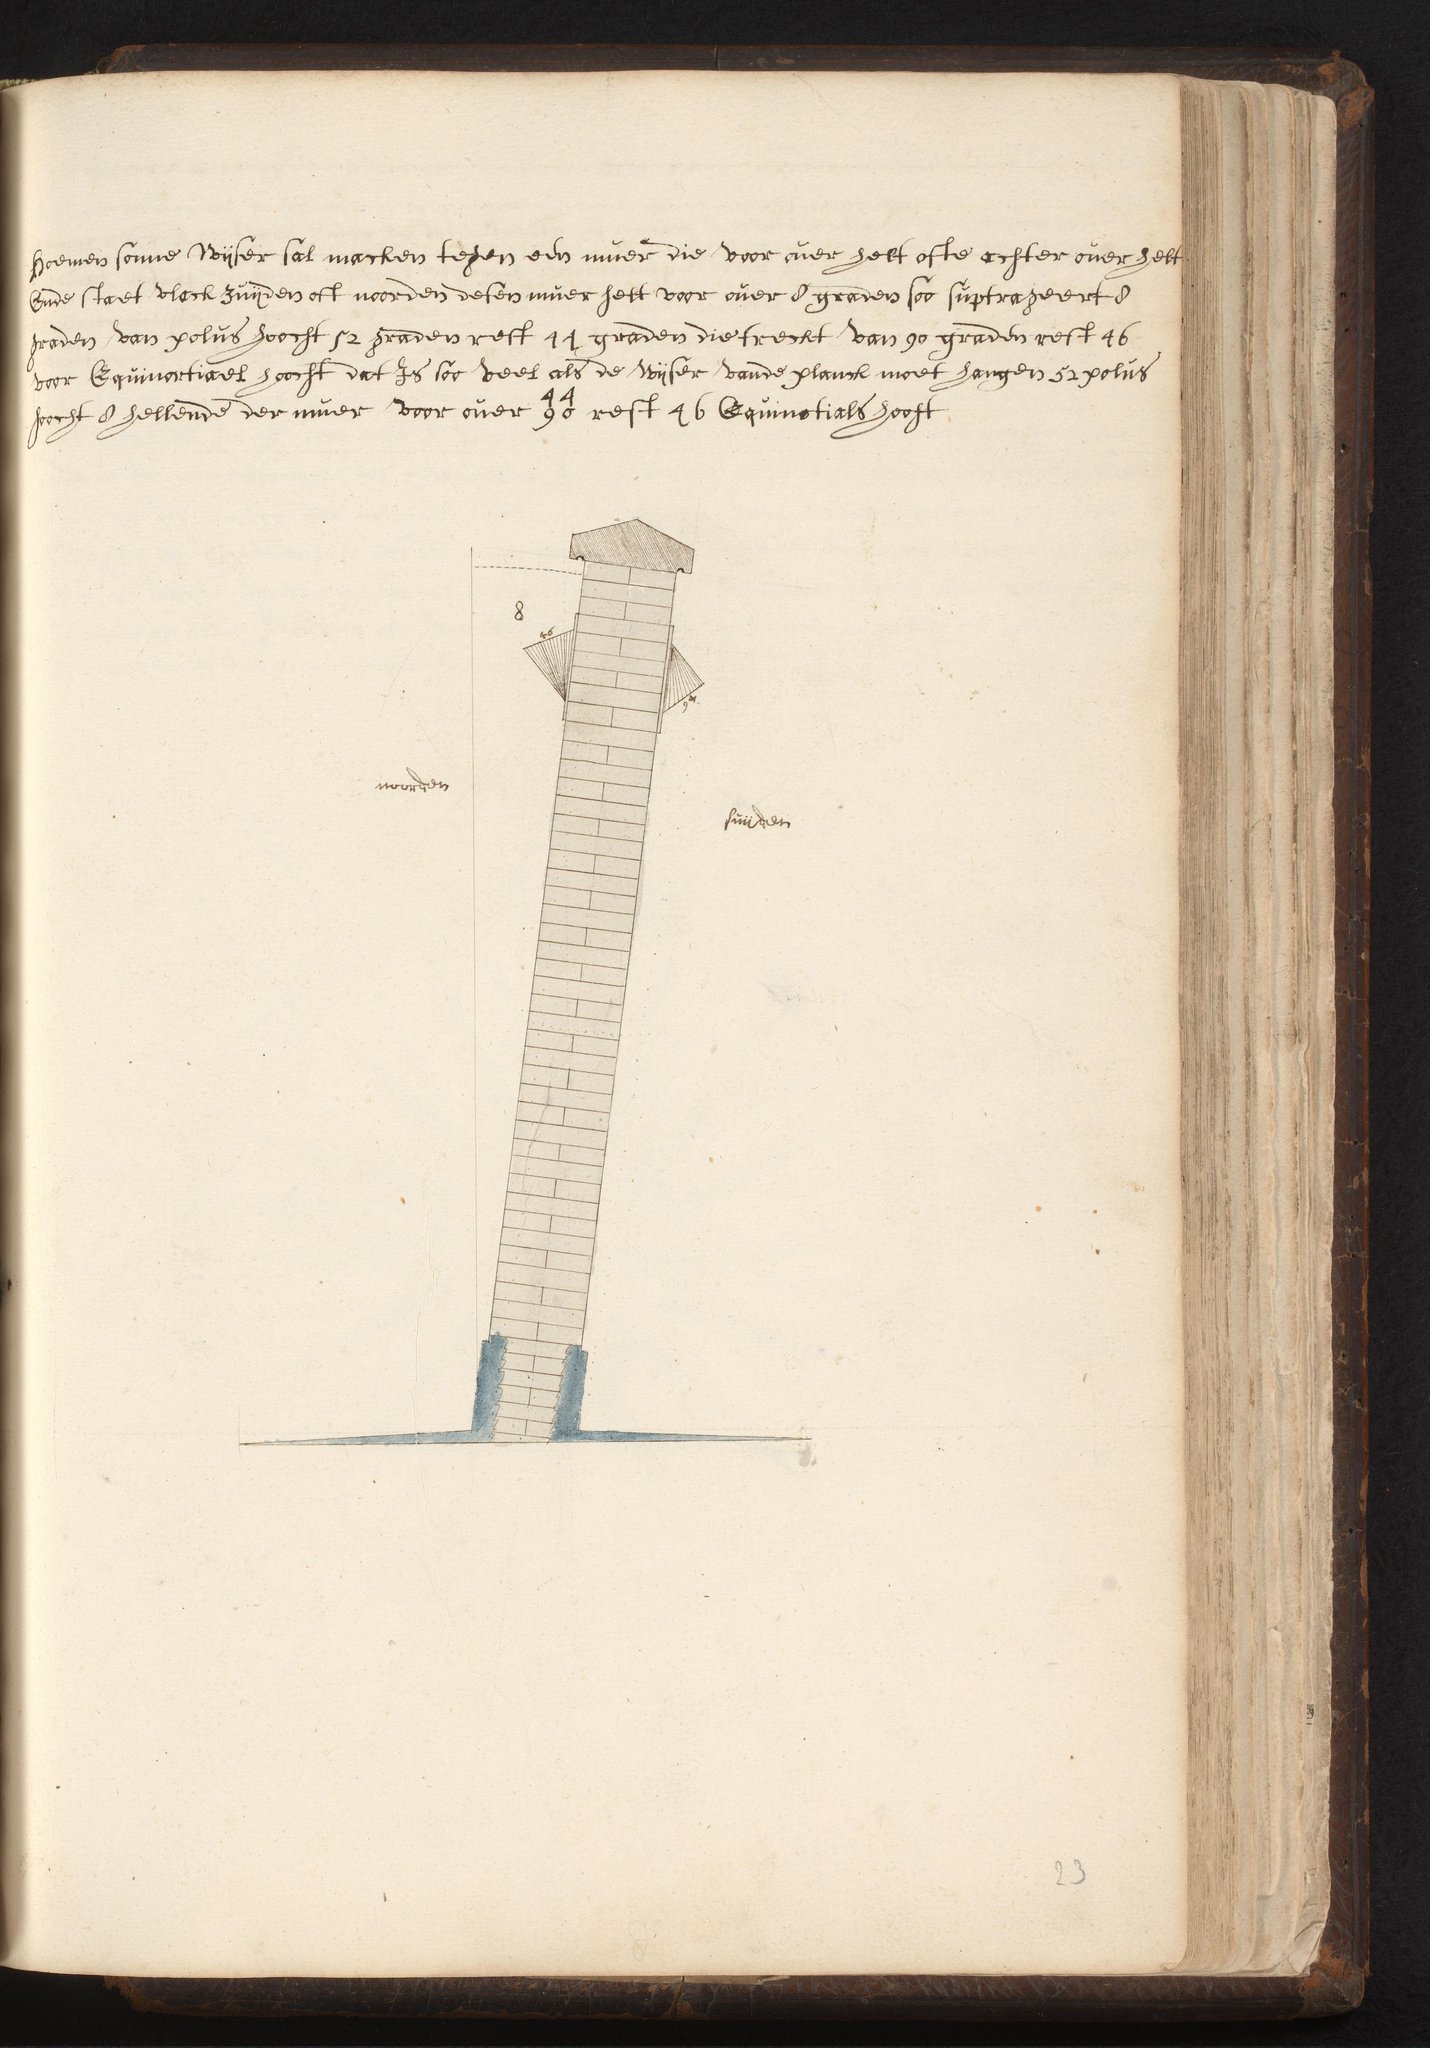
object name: album leaf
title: Hoemen sonnewijser sal macken tegen een muer die voorover gaet ofte achter over gaet (...)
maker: Anonymous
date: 1650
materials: ink, paper, pencil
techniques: brush, pen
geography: low countries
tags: sundial